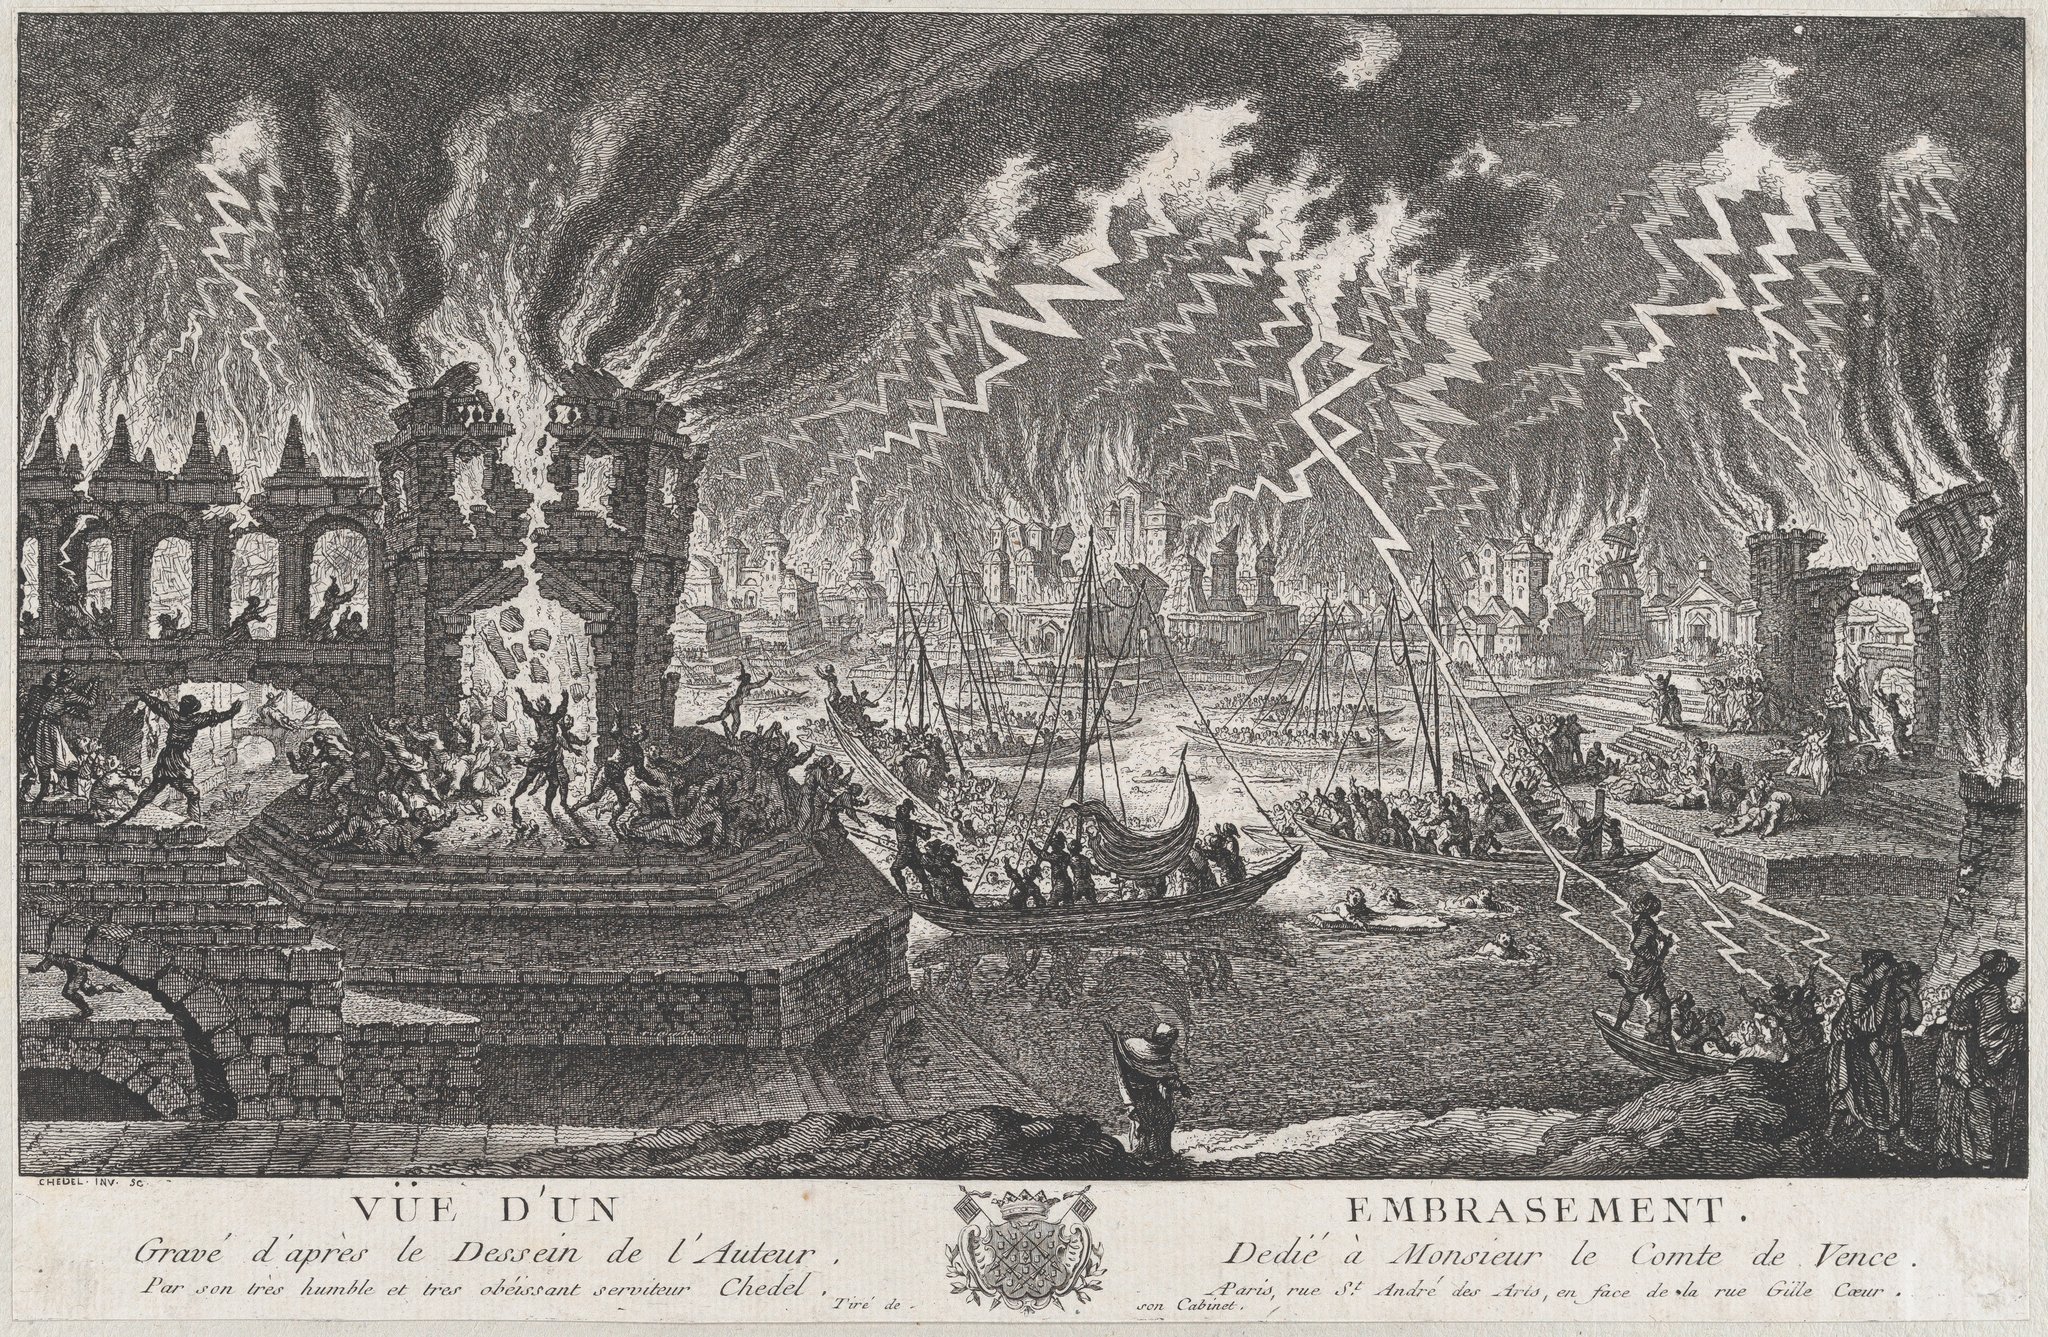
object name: print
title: Vue d'un embrasement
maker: quentin pierre chedel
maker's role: artist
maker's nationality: french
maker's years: 1705-1763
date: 1701-1800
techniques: etching